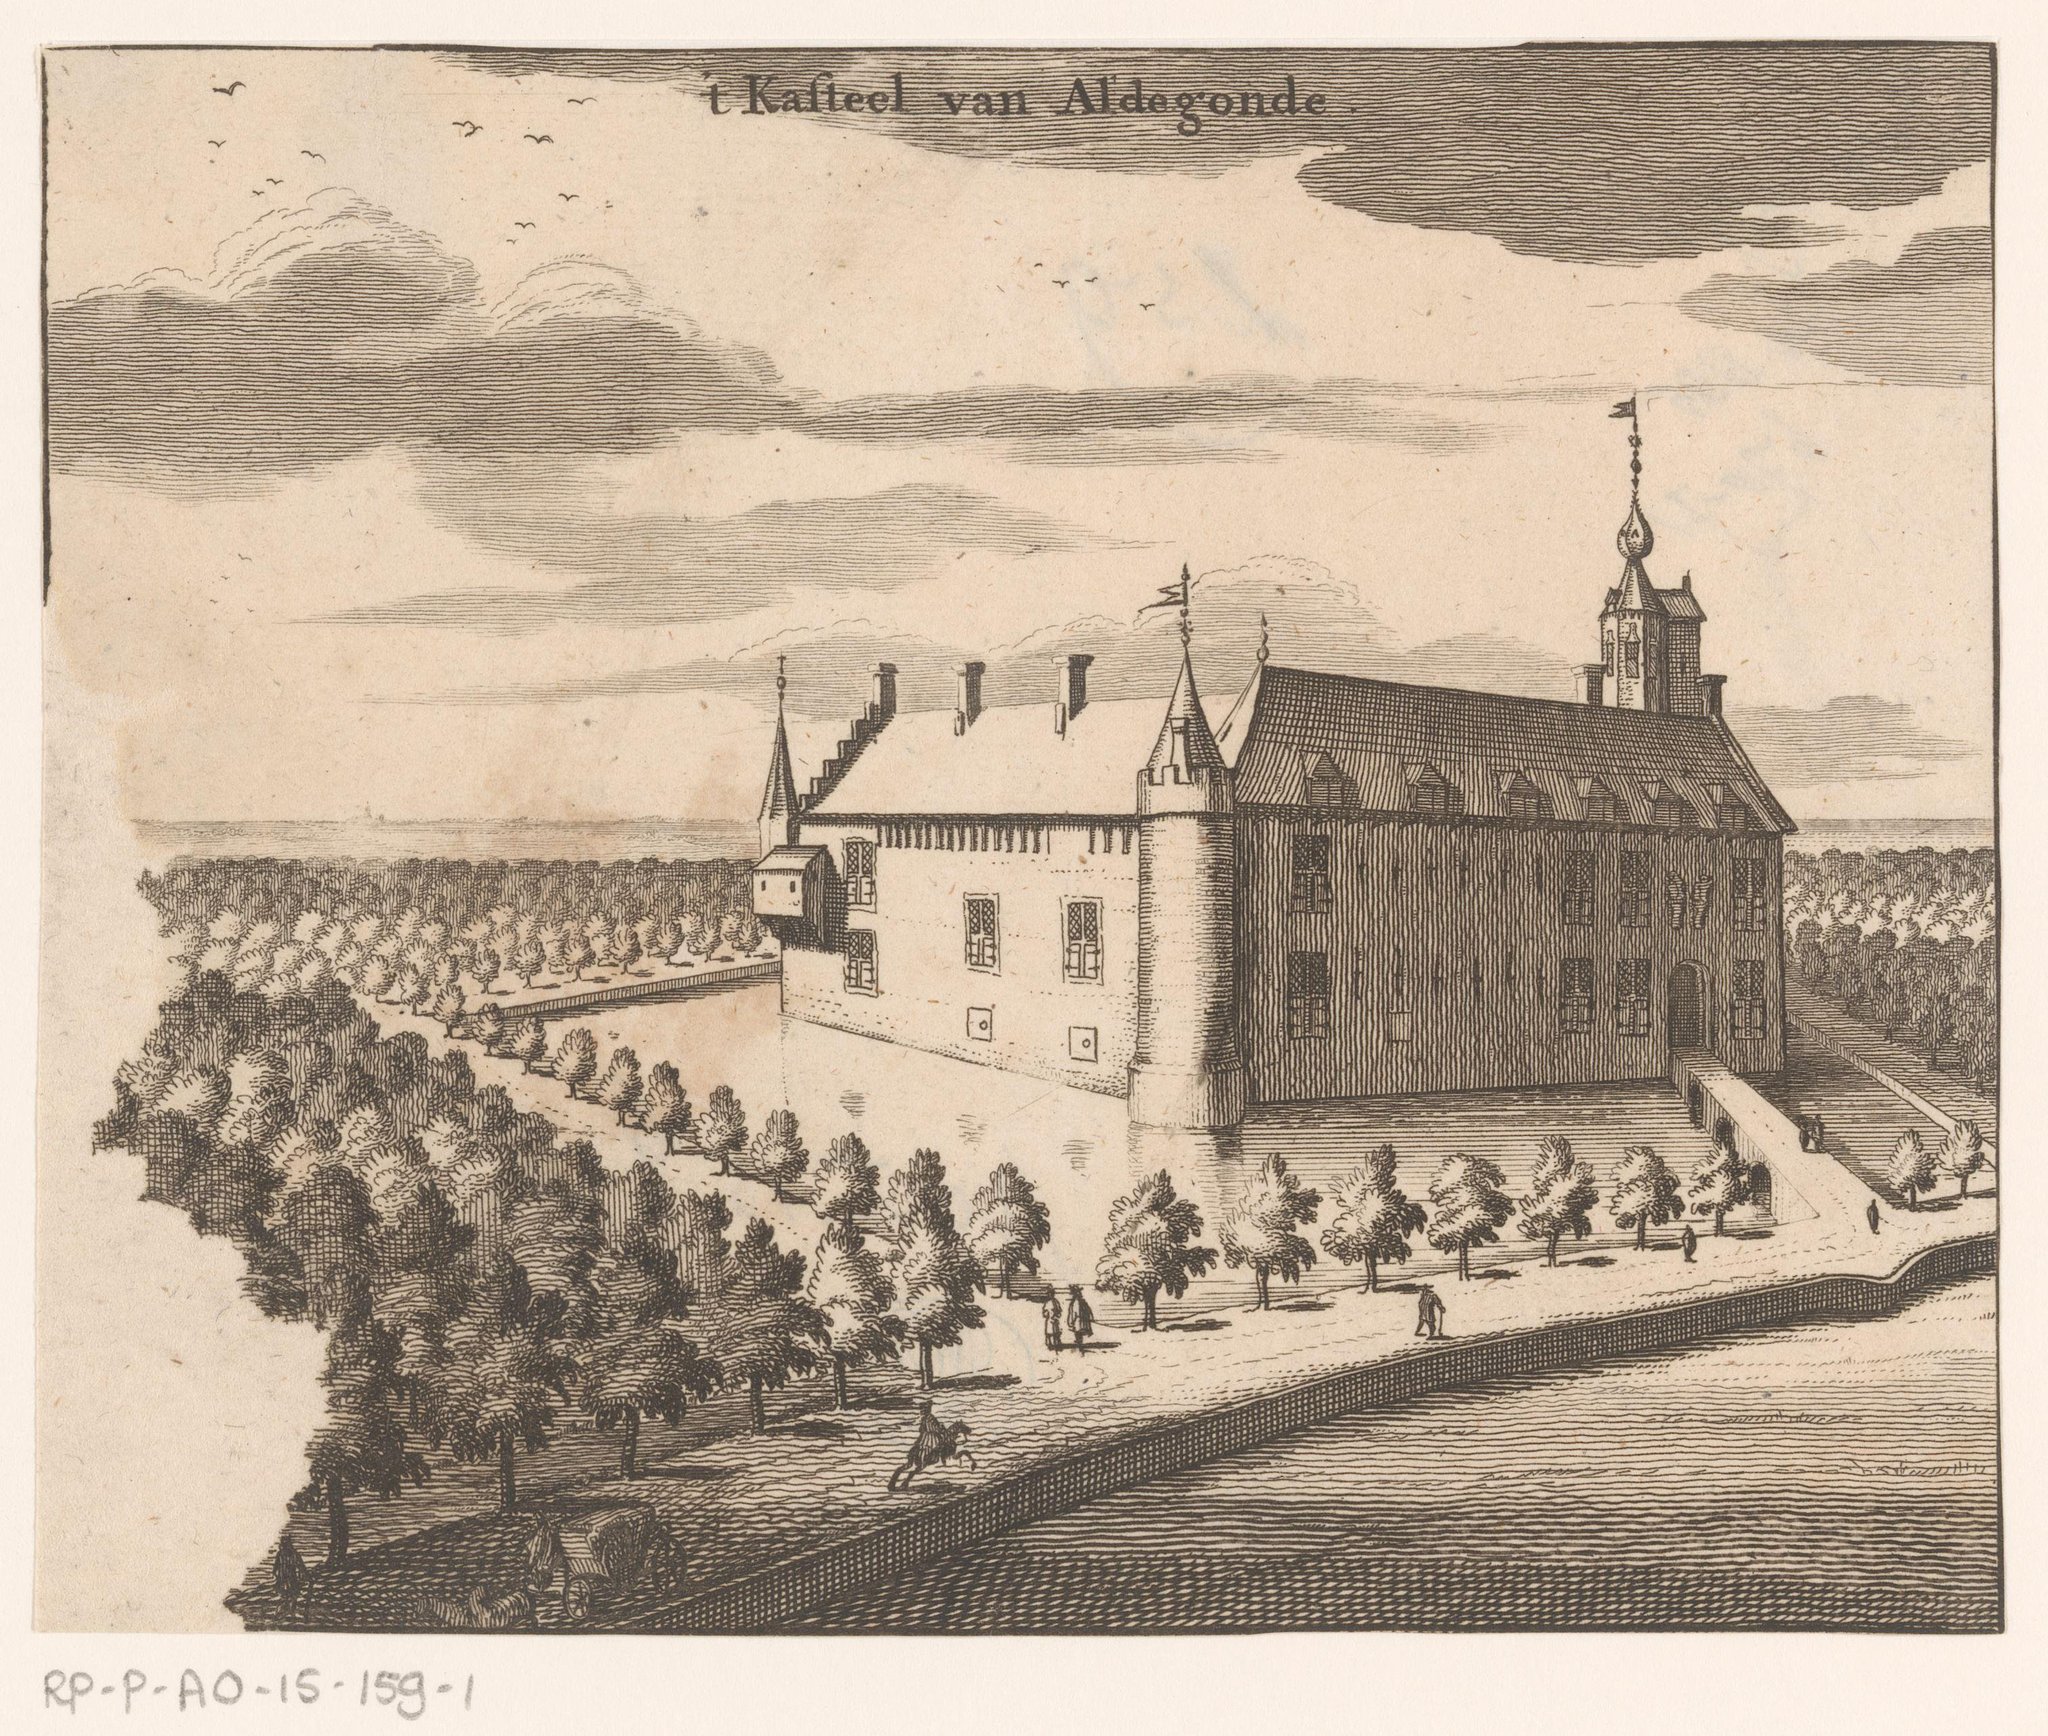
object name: print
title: 't Kasteel van Aldegonde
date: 1696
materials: paper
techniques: engraving, etching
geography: middelburg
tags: castle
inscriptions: collector's mark: Lugt 195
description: Oorspronkelijk van één plaat gedrukt met drie andere voorstellingen (zie RP-P-AO-15-154 en RP-P-AO-15-159-26). Prent in zijn geheel ook gebruikt in: Smallegange, Mattheus. Nieuwe Cronyk van Zeeland (…). Middelburg en Amsterdam: Johannes Meertens en Abraham van Someren, 1696. Huidige voorstelling later (plaat mogelijk versneden) met andere voorstelling van zelfde plaat en apart gedrukte sierrand ook gebruikt in: Aa, Pieter van der. La galerie agreable du monde (...). 66 delen. Leiden: Pieter van der Aa, 1728, dl. 20.